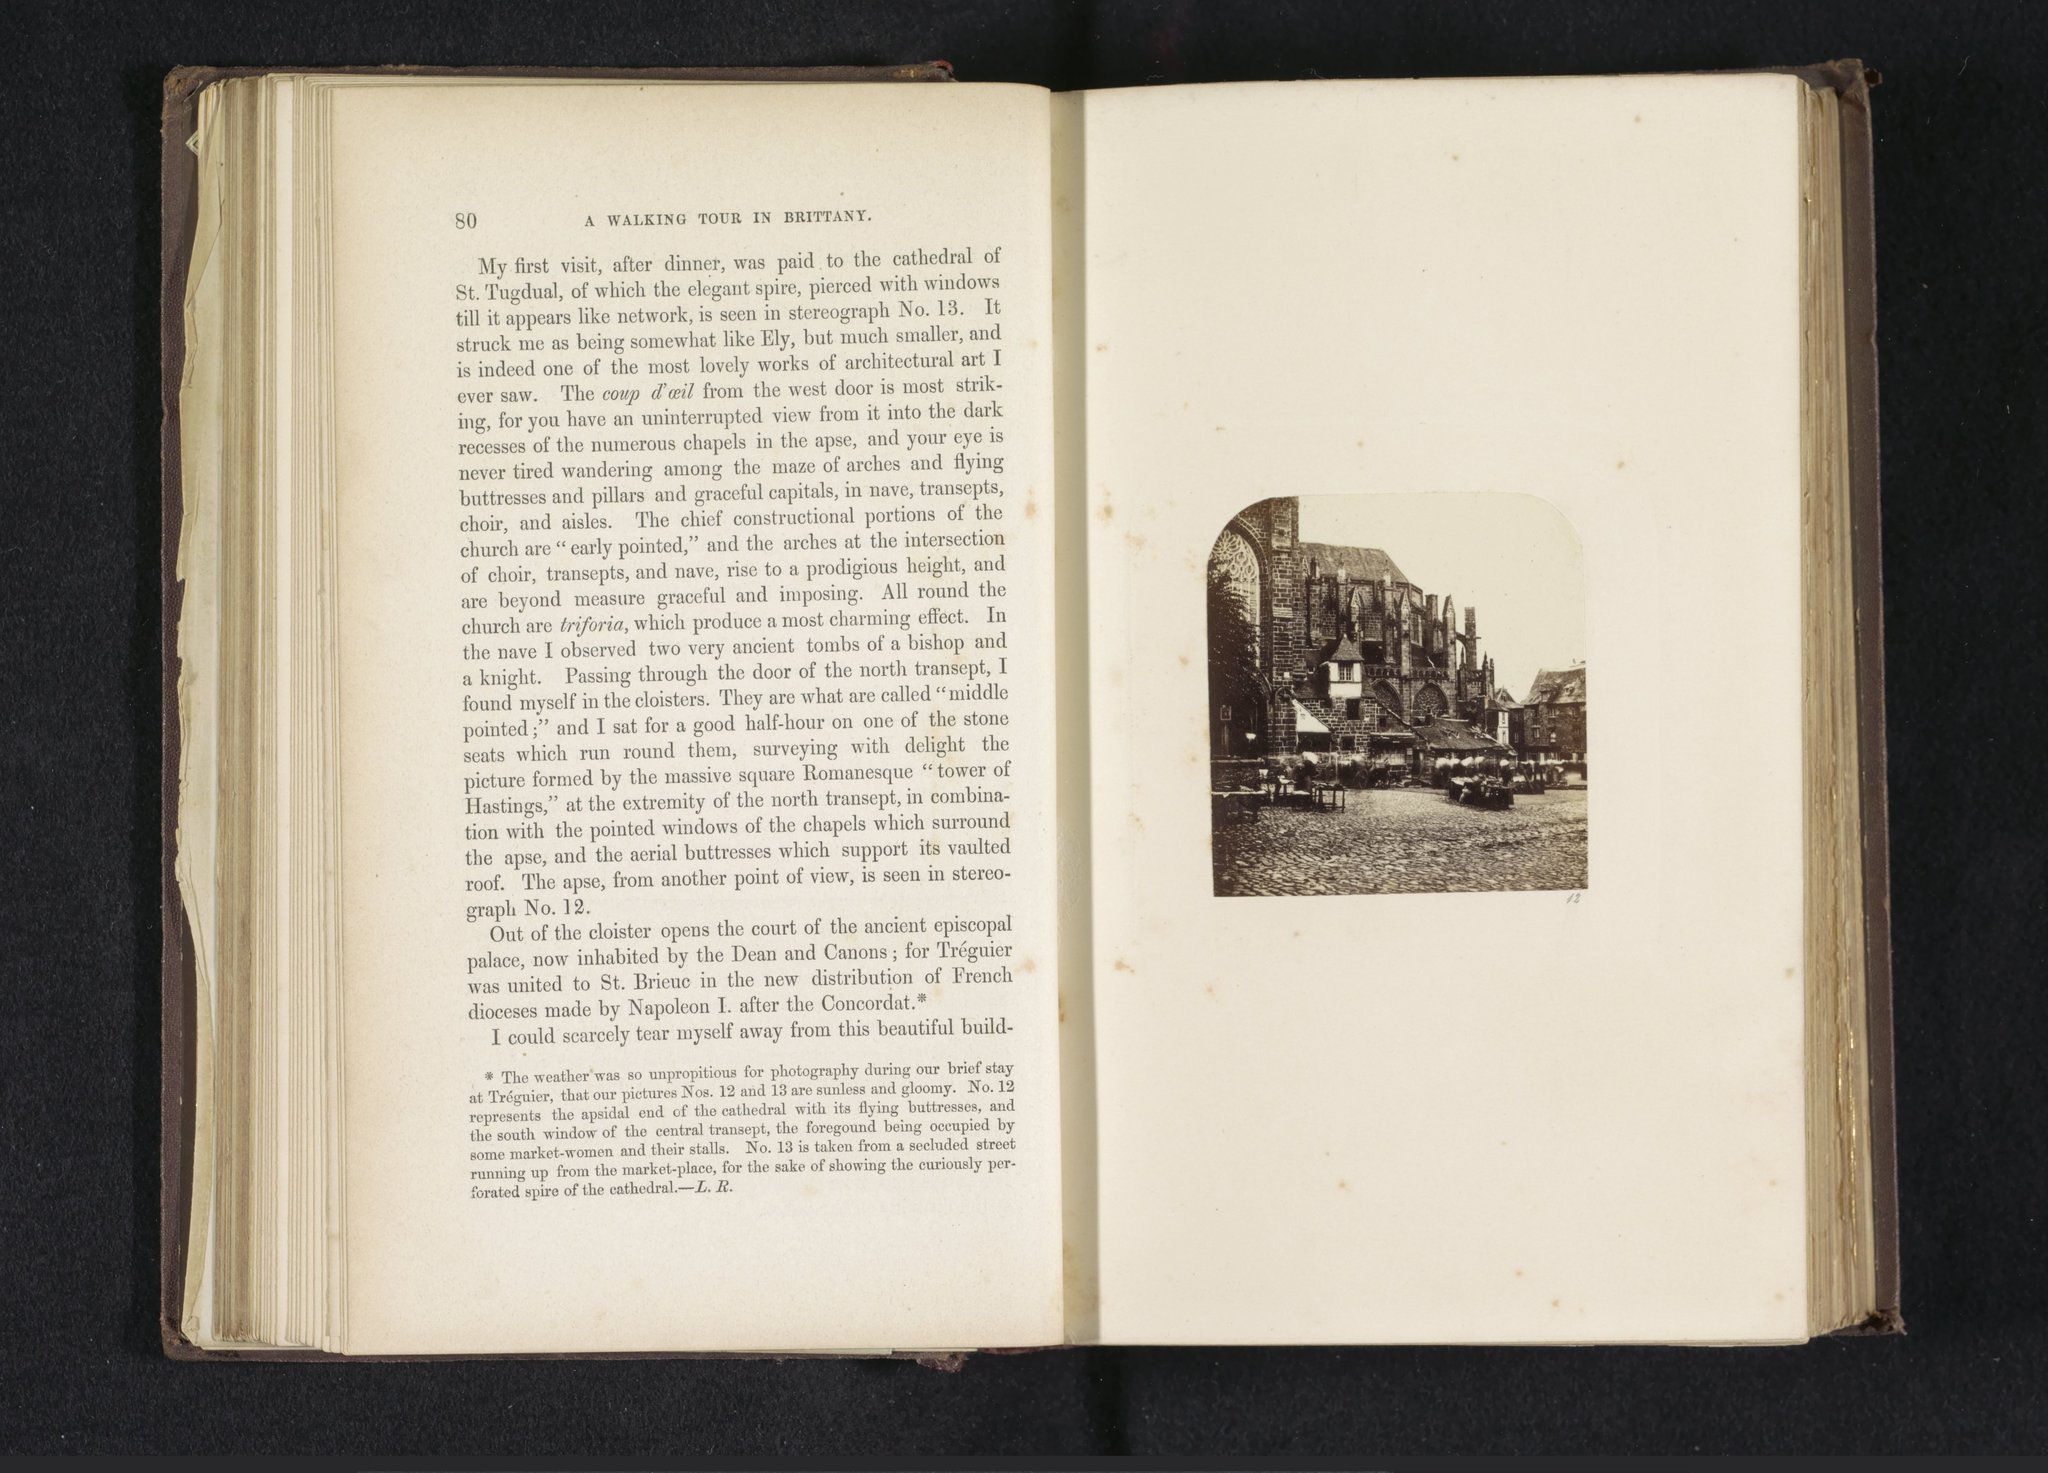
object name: page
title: Apsis en zuidtransept van de kathedraal van Tréguier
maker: taylor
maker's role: fotograaf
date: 1850-1859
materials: photographic support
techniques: albumen print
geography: tréguier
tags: church (exterior)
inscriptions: number: ‘12’